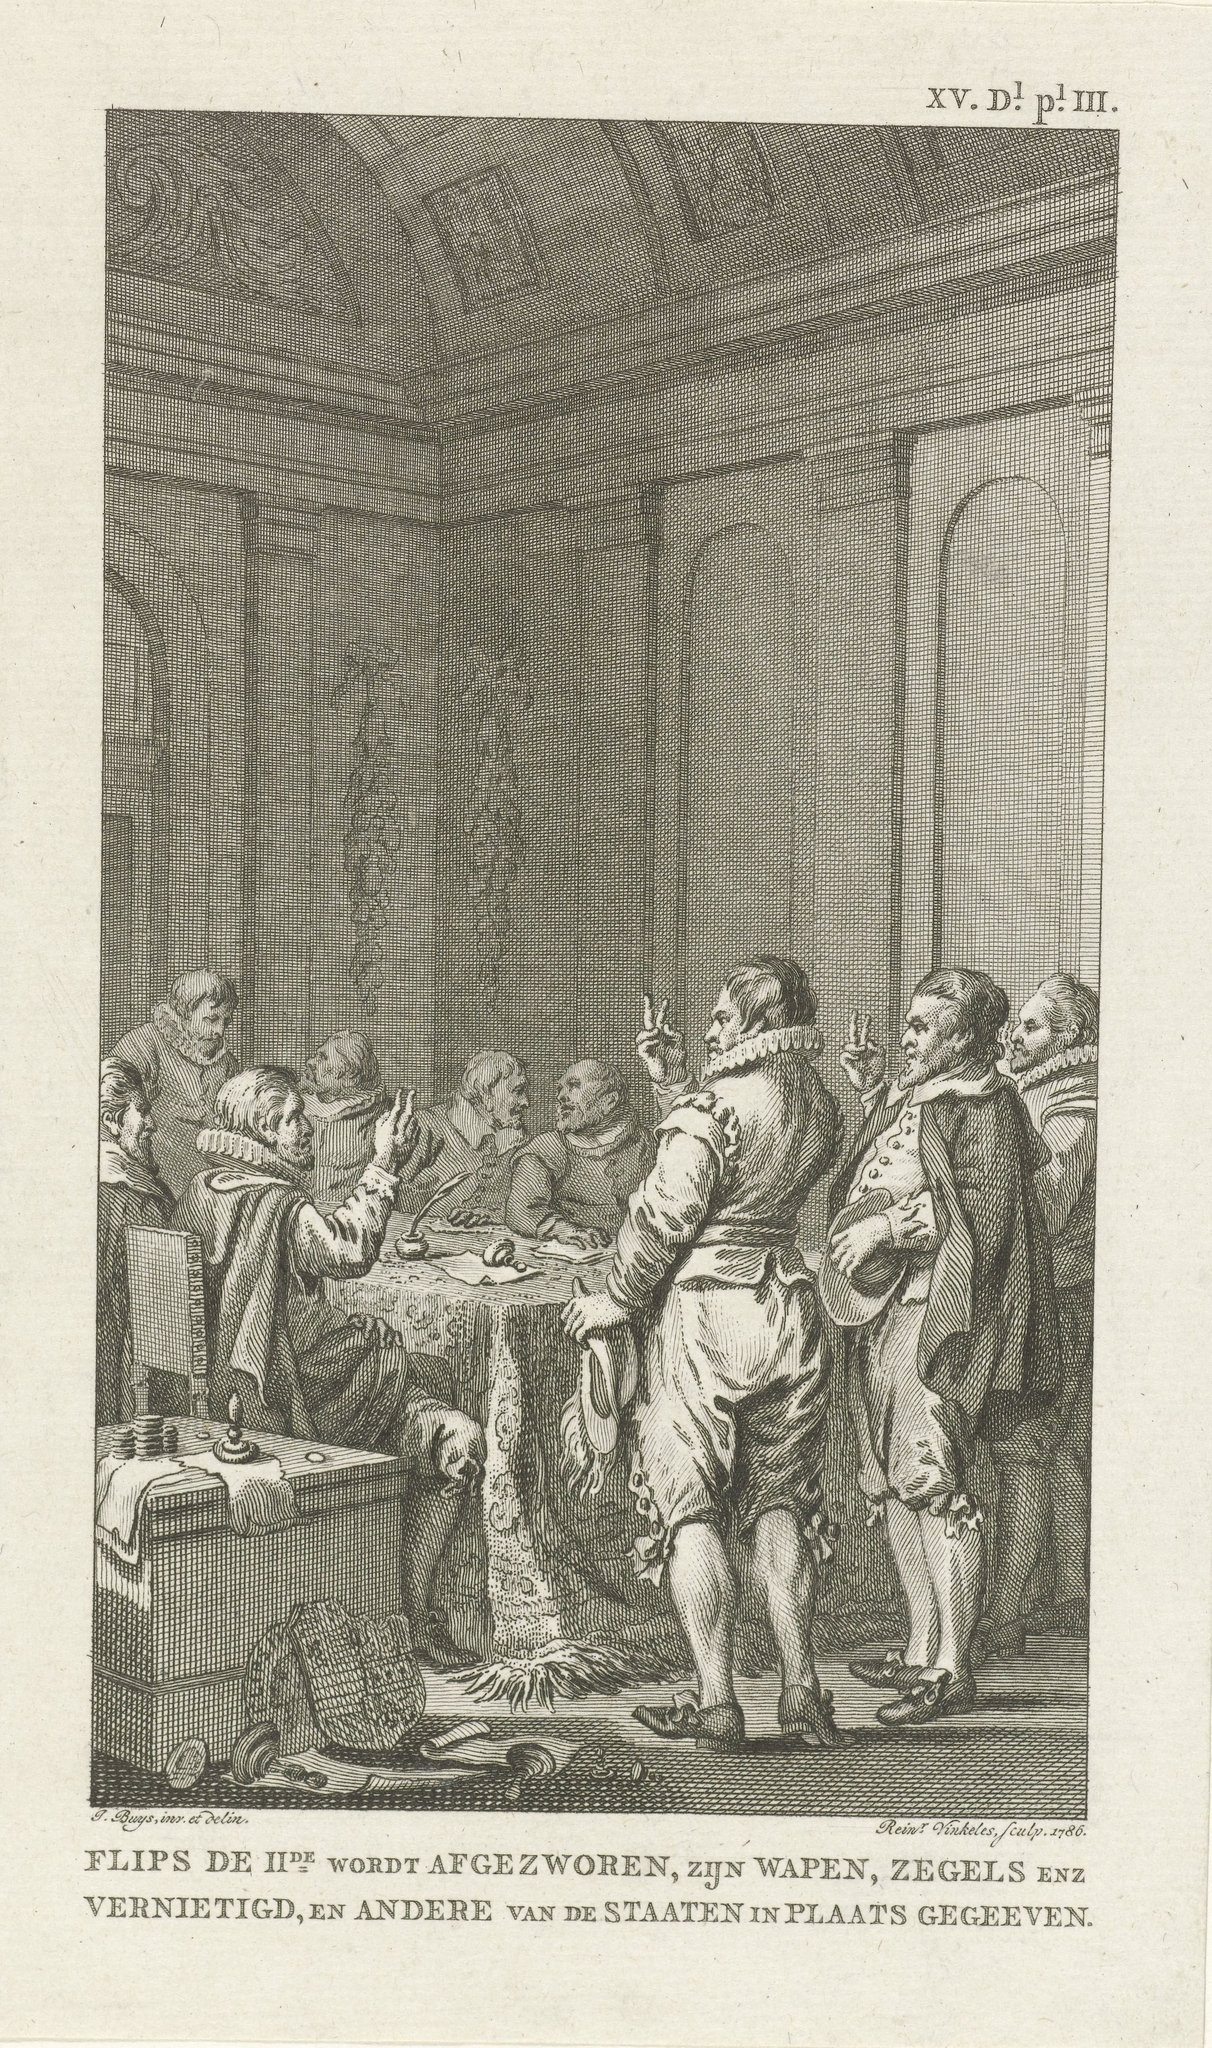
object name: history print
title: Het afzweren van Filips II door de Staten, 1581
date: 1786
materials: paper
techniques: etching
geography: netherlands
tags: philip ii of spain, involuntary abdication (of a ruler), swearing an oath (with two fingers raised)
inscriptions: date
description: Het afzweren van de Spaanse koning Filips II door de Staten, 26 juli 1581. Interieur waarin leden van de Staten-Generaal de eed afleggen. Op de grond het verbroken wapen en zegels van Filips II.